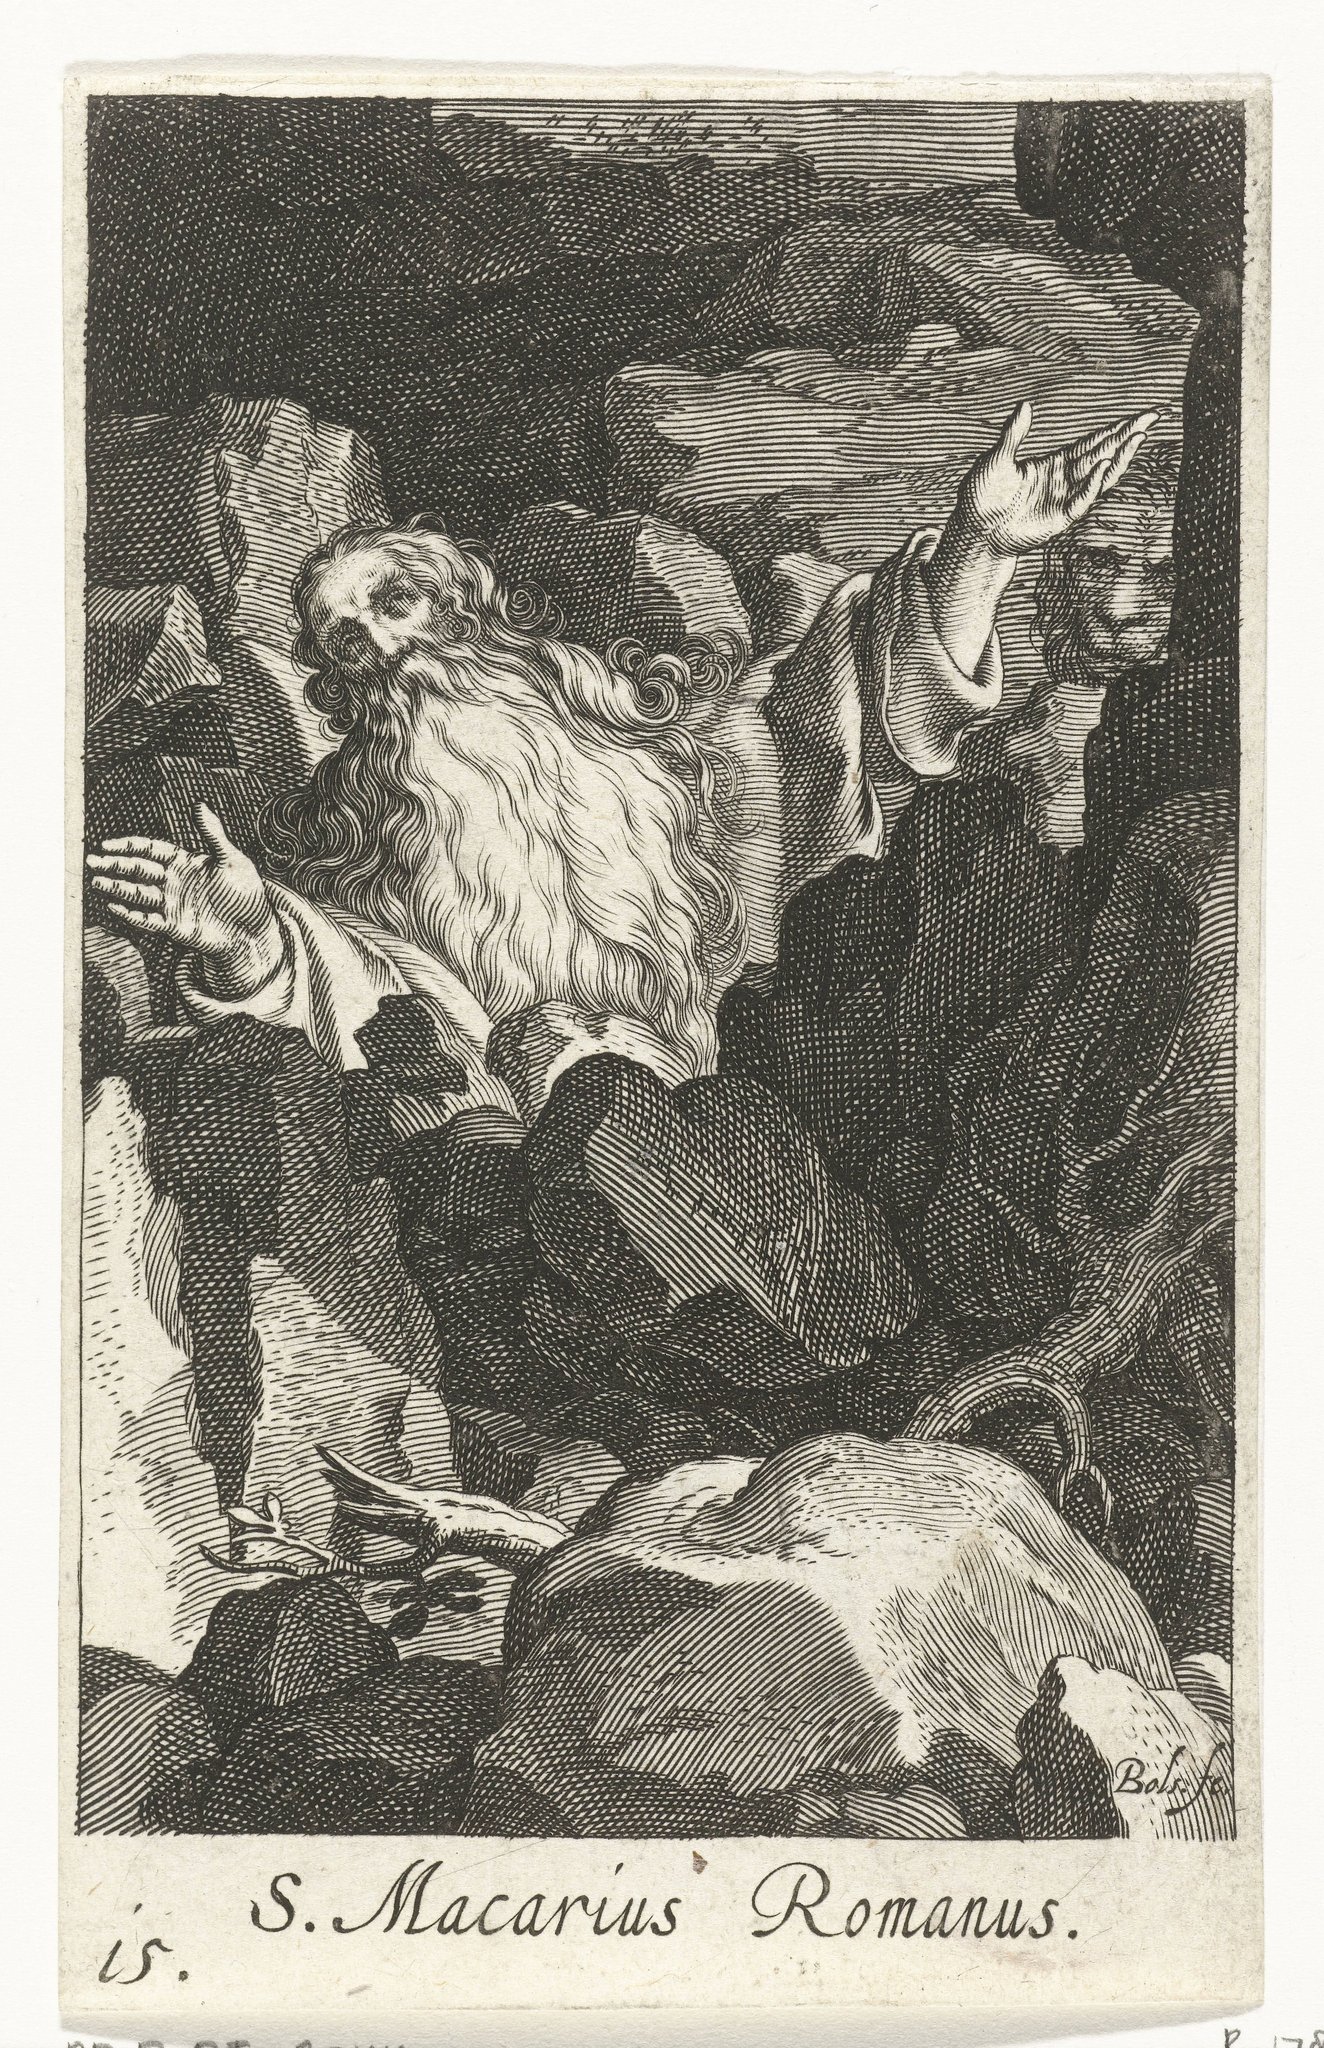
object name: book illustration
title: S. Macarius Romanus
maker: boëtius adamsz. bolswert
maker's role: print maker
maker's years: 1580-1633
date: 1590-1612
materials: paper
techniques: engraving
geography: amsterdam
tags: anchorite, hermit, the hermit macarius of egypt (the elder, the great); possible attributes: t-shaped staff, skull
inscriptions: collector's mark: Lugt 240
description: Prent uit: Sacra eremus ascetarum, geen plaats, Boëtius Adamsz. Bolswert, 1619. Eerste gebonden uitgave met in totaal vijftig prenten. Prent uit serie van vijfentwintig mannelijke kluizenaars. In 1612 verscheen een ongebonden editie maar op basis van de gewijzigde opschriften en samenstelling wordt aangenomen dat de prenten van de uitgave 1619 ook in 1612 of iets daarvoor gedrukt werden. Roethlisberger beschouwt de uitgave van 1619 als de eerste staat en de ongebonden editie van 1612 als de tweede staat (Roethlisberger 1993, p. 171, 172). De prent verscheen alleen in de uitgave van 1619.